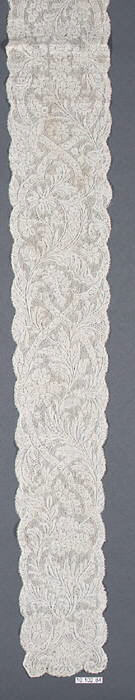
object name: barbe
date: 1701-1733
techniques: lace